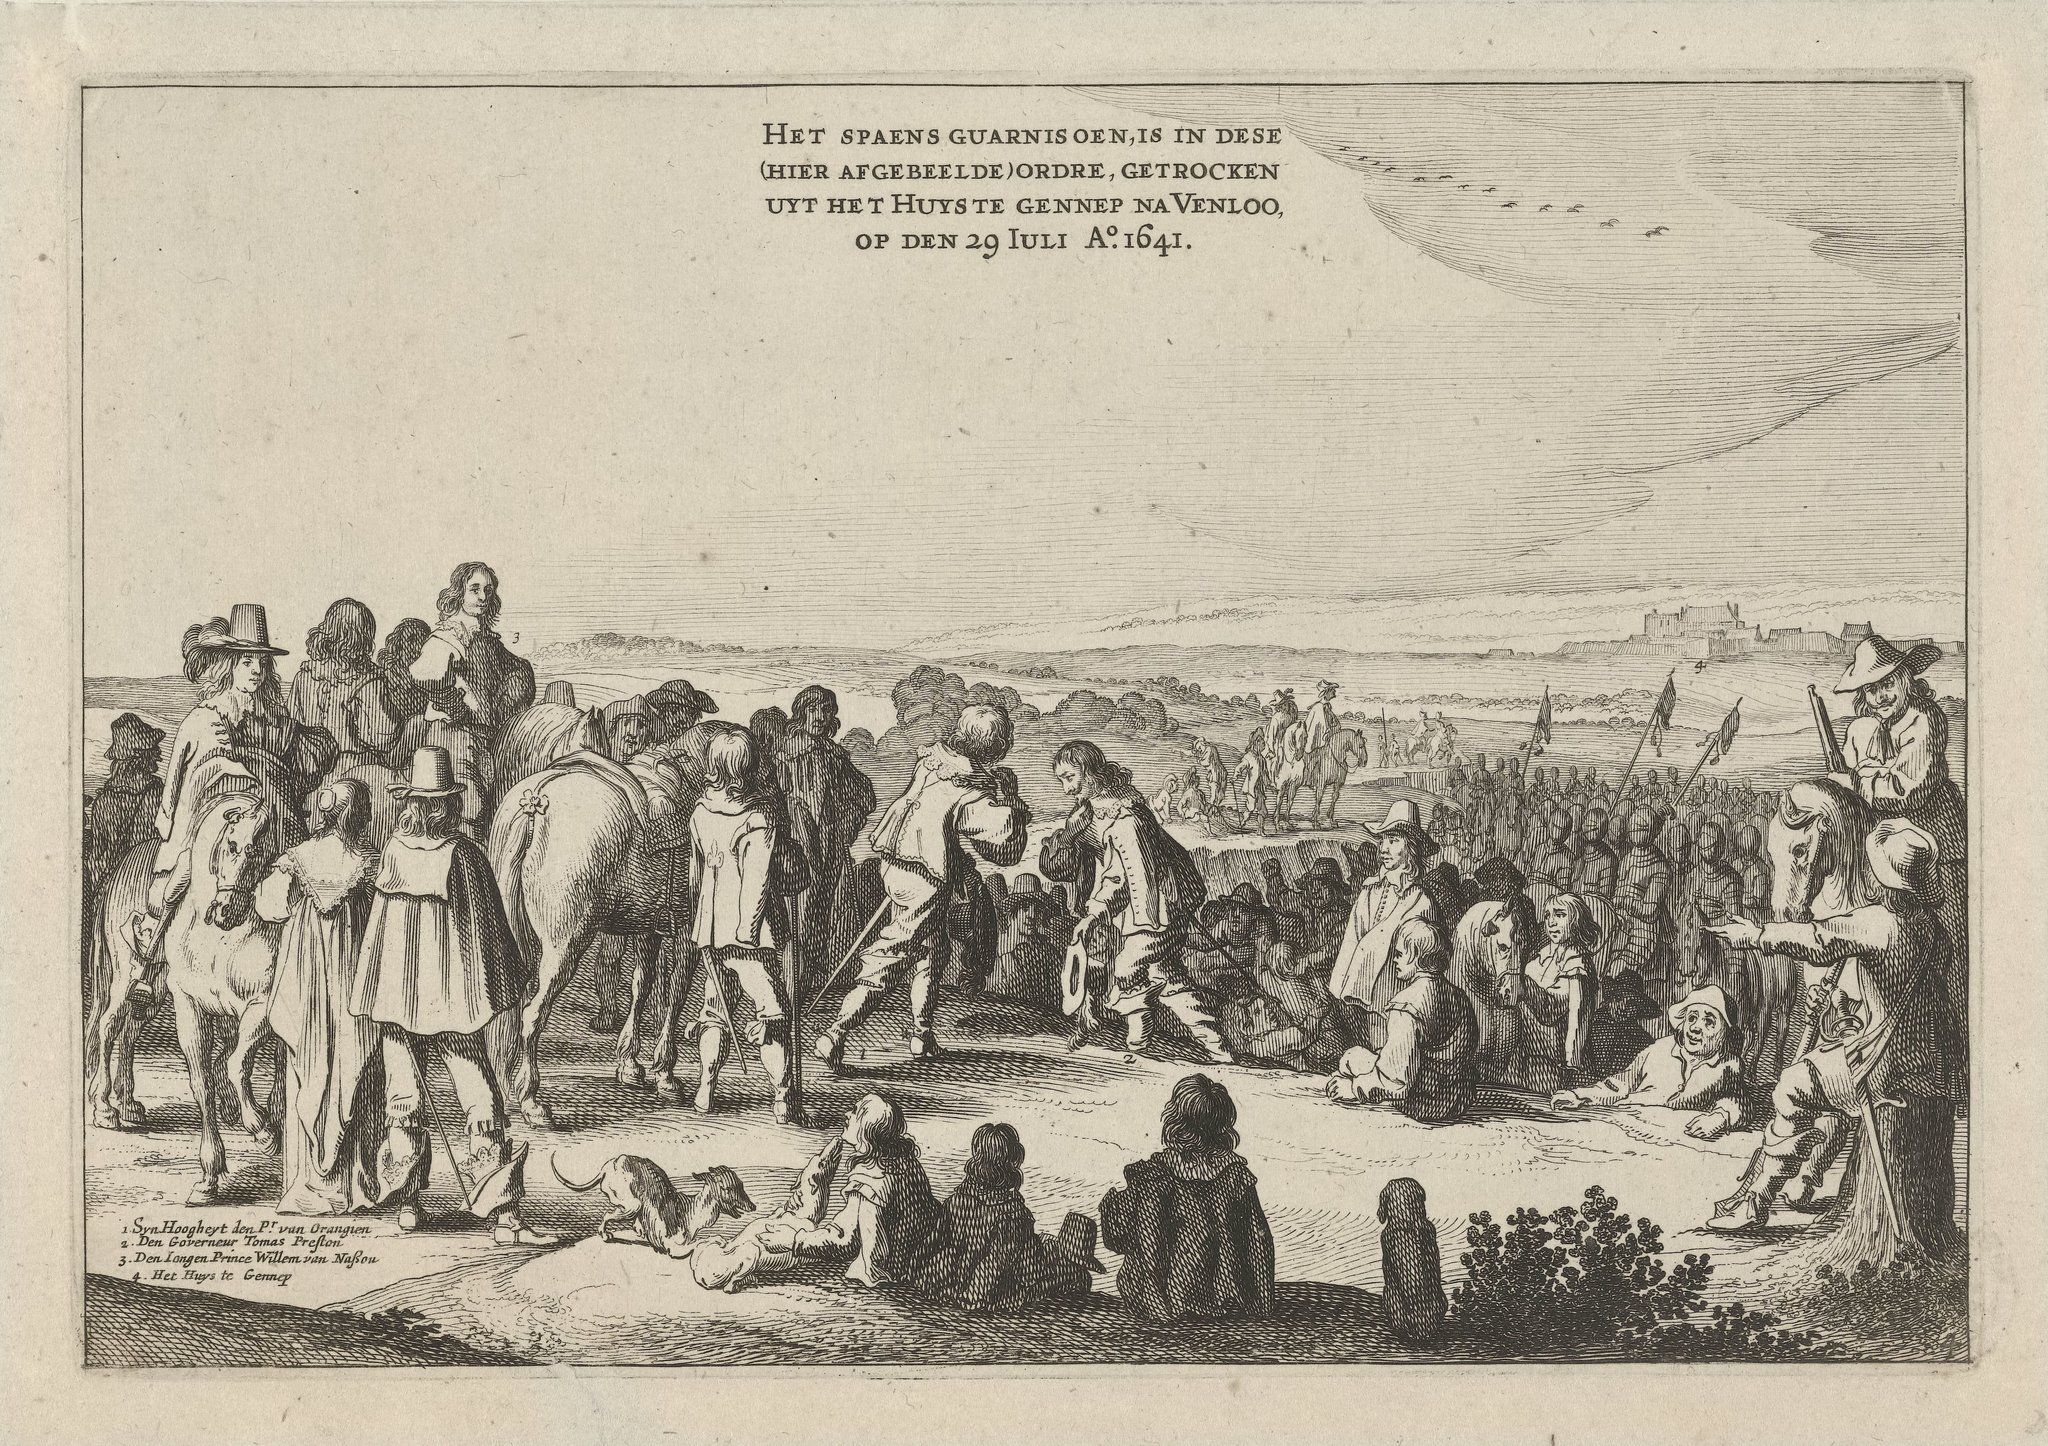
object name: print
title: Ontmoeting tussen Frederik Hendrik en Thomas Preston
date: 1641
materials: paper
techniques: engraving, etching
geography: amsterdam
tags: frederick henry (prince of orange), william ii (prince of orange), paris, troop movements, transportation, retreat of the defeated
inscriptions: collector's mark: Lugt 240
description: Vertrek van het Spaanse garnizoen uit Huis te Gennep op 29 juli 1641, na het beleg en de verovering van het Huis te Gennep door het Staatse leger onder Frederik Hendrik van 6 juni tot en met 27 juli 1641. Op de voorgrond de ontmoeting van Frederik Hendrik met de Ierse gouverneur Thomas Preston. Links prins Willem II te paard gezeten en op de achtergrond het Huis te Gennep. Achter de ontmoeting trekt een stoet Spaanse ruiters langs. Bovenaan een vierregelige tekst in het Nederlands. Prent maakt deel uit van een serie over het vertrek van het Spaanse garnizoen uit Gennep.